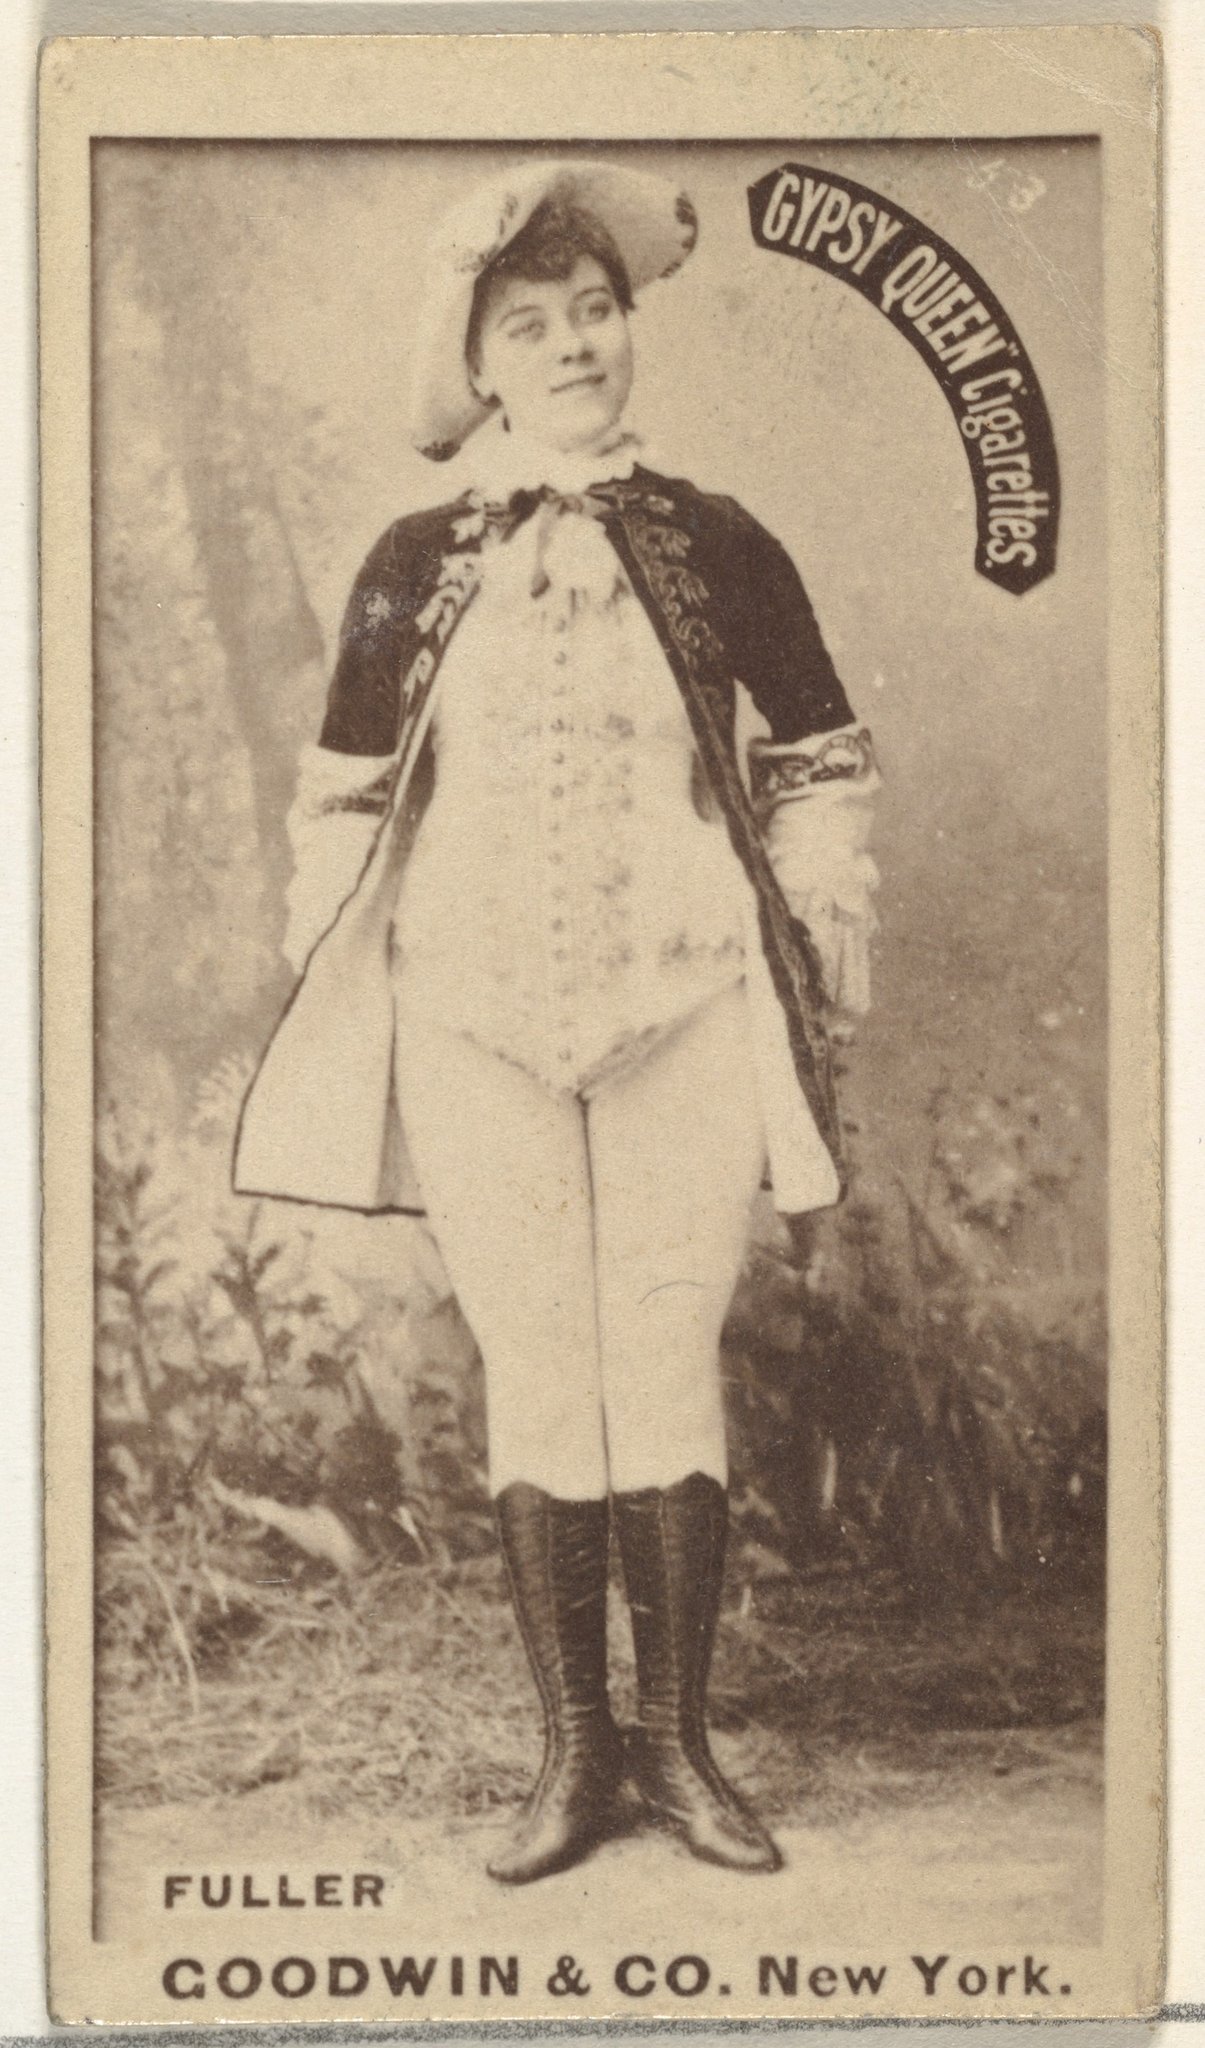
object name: photograph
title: Fuller, from the Actors and Actresses series (N171) for Gypsy Queen Cigarettes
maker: goodwin & company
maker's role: publisher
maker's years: 1850-1950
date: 1886-1890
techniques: albumen silver print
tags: portraits,women,actresses